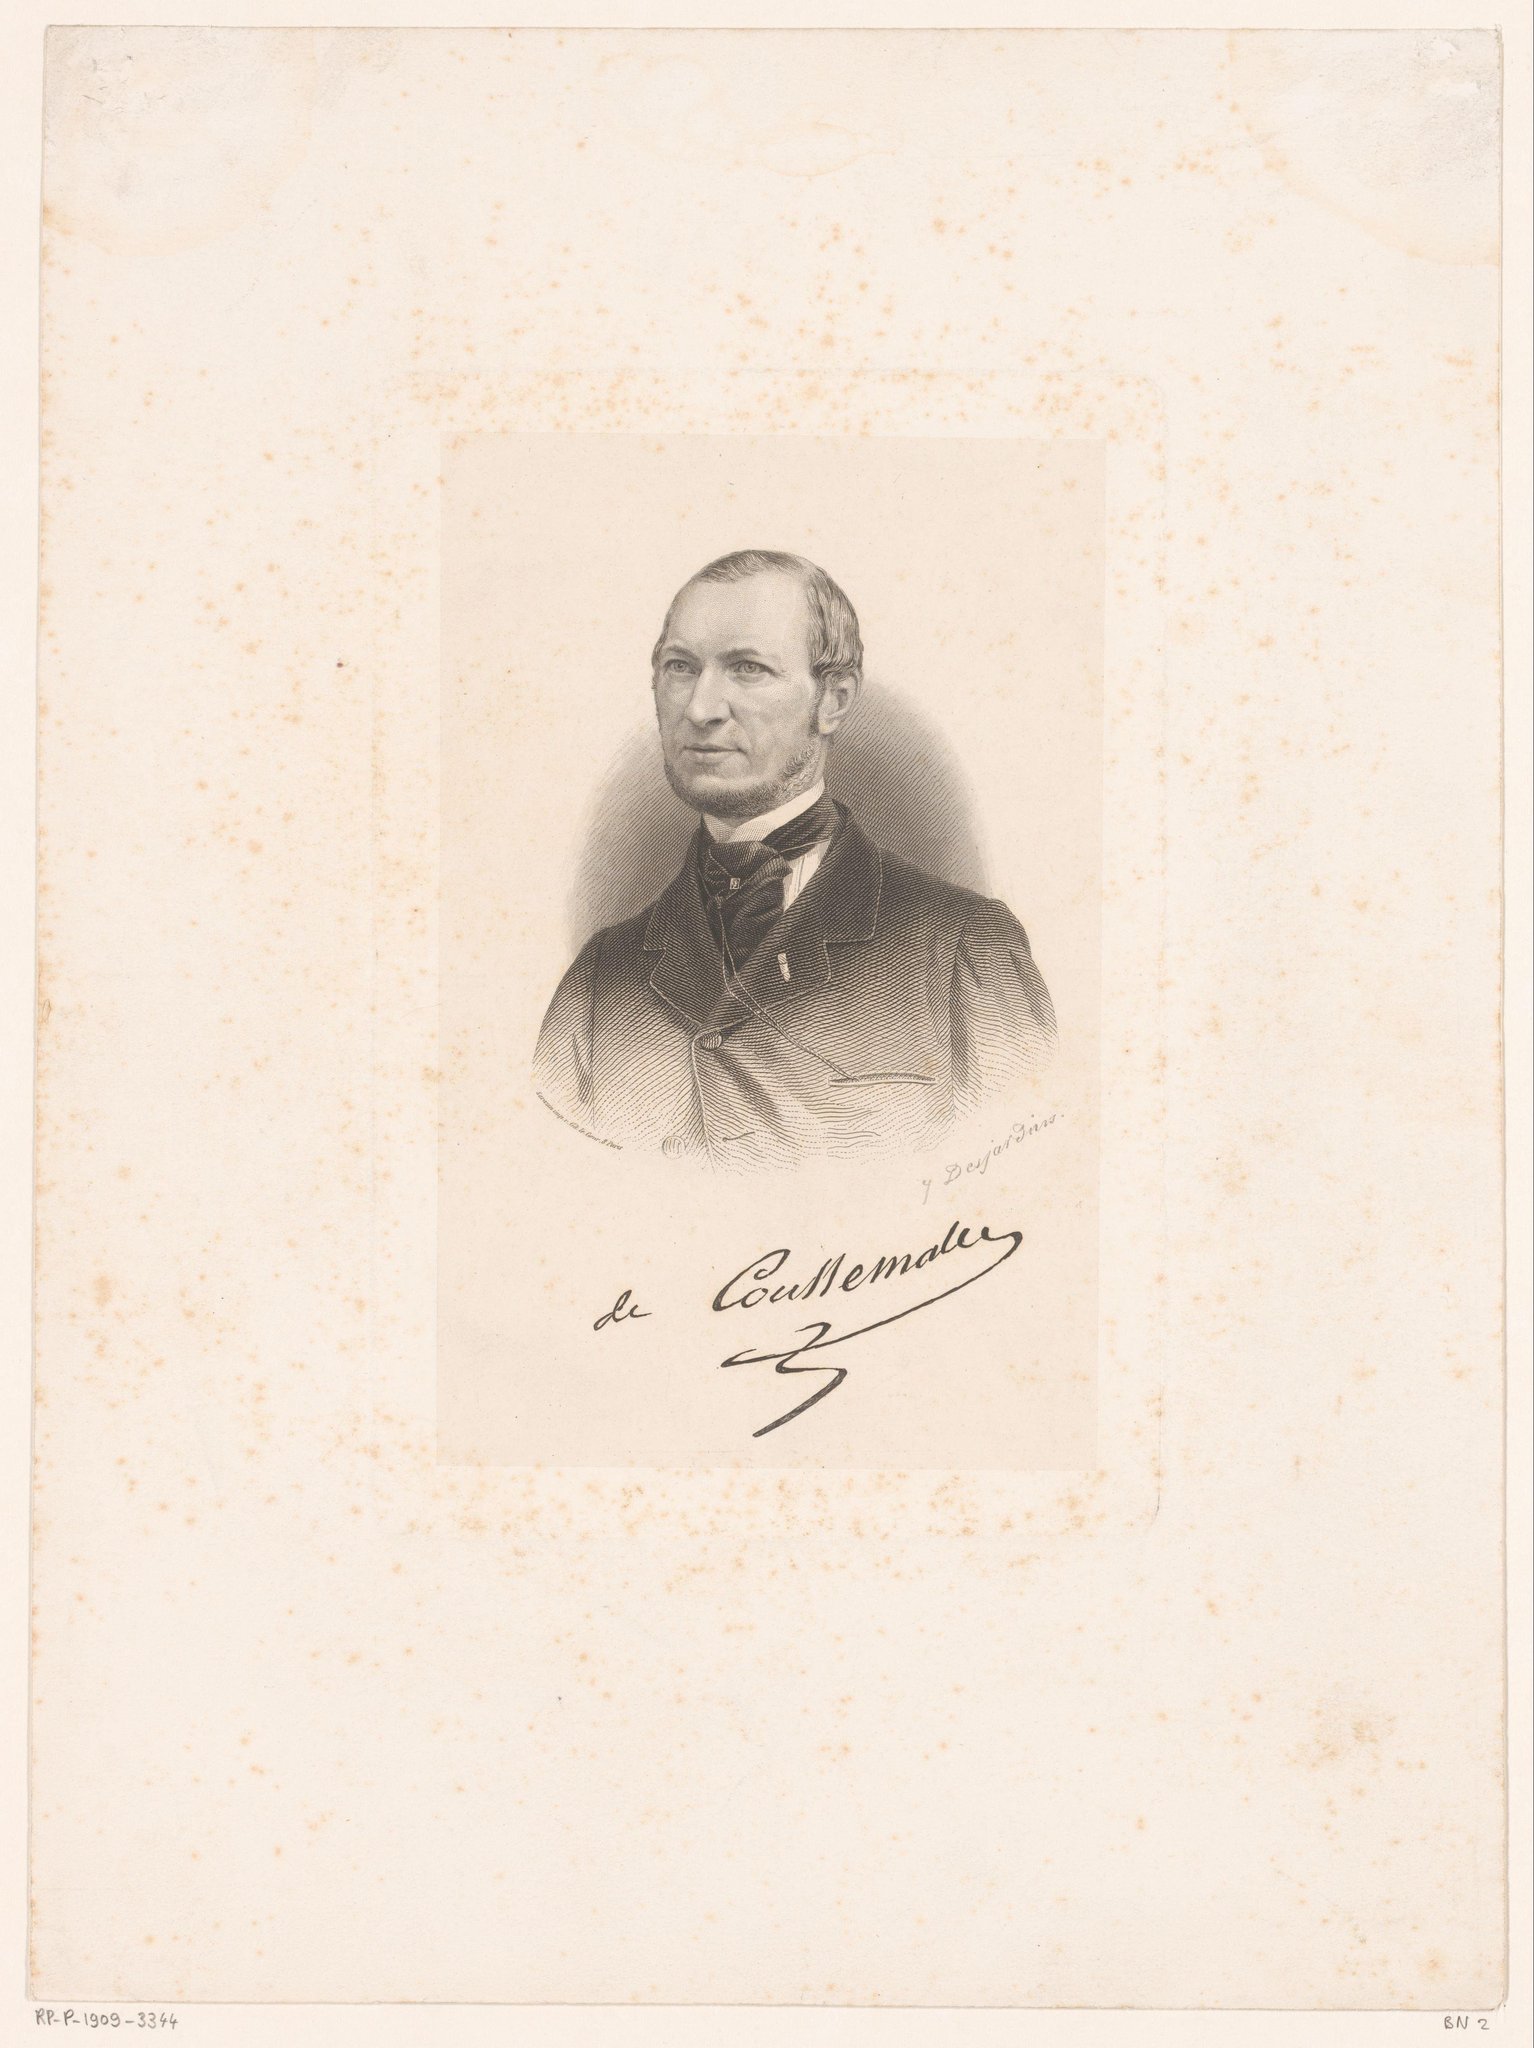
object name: print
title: Portret van de Edmond de Coussemaker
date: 1860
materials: paper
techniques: engraving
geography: paris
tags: lille, historical persons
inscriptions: collector's mark: Lugt 2228